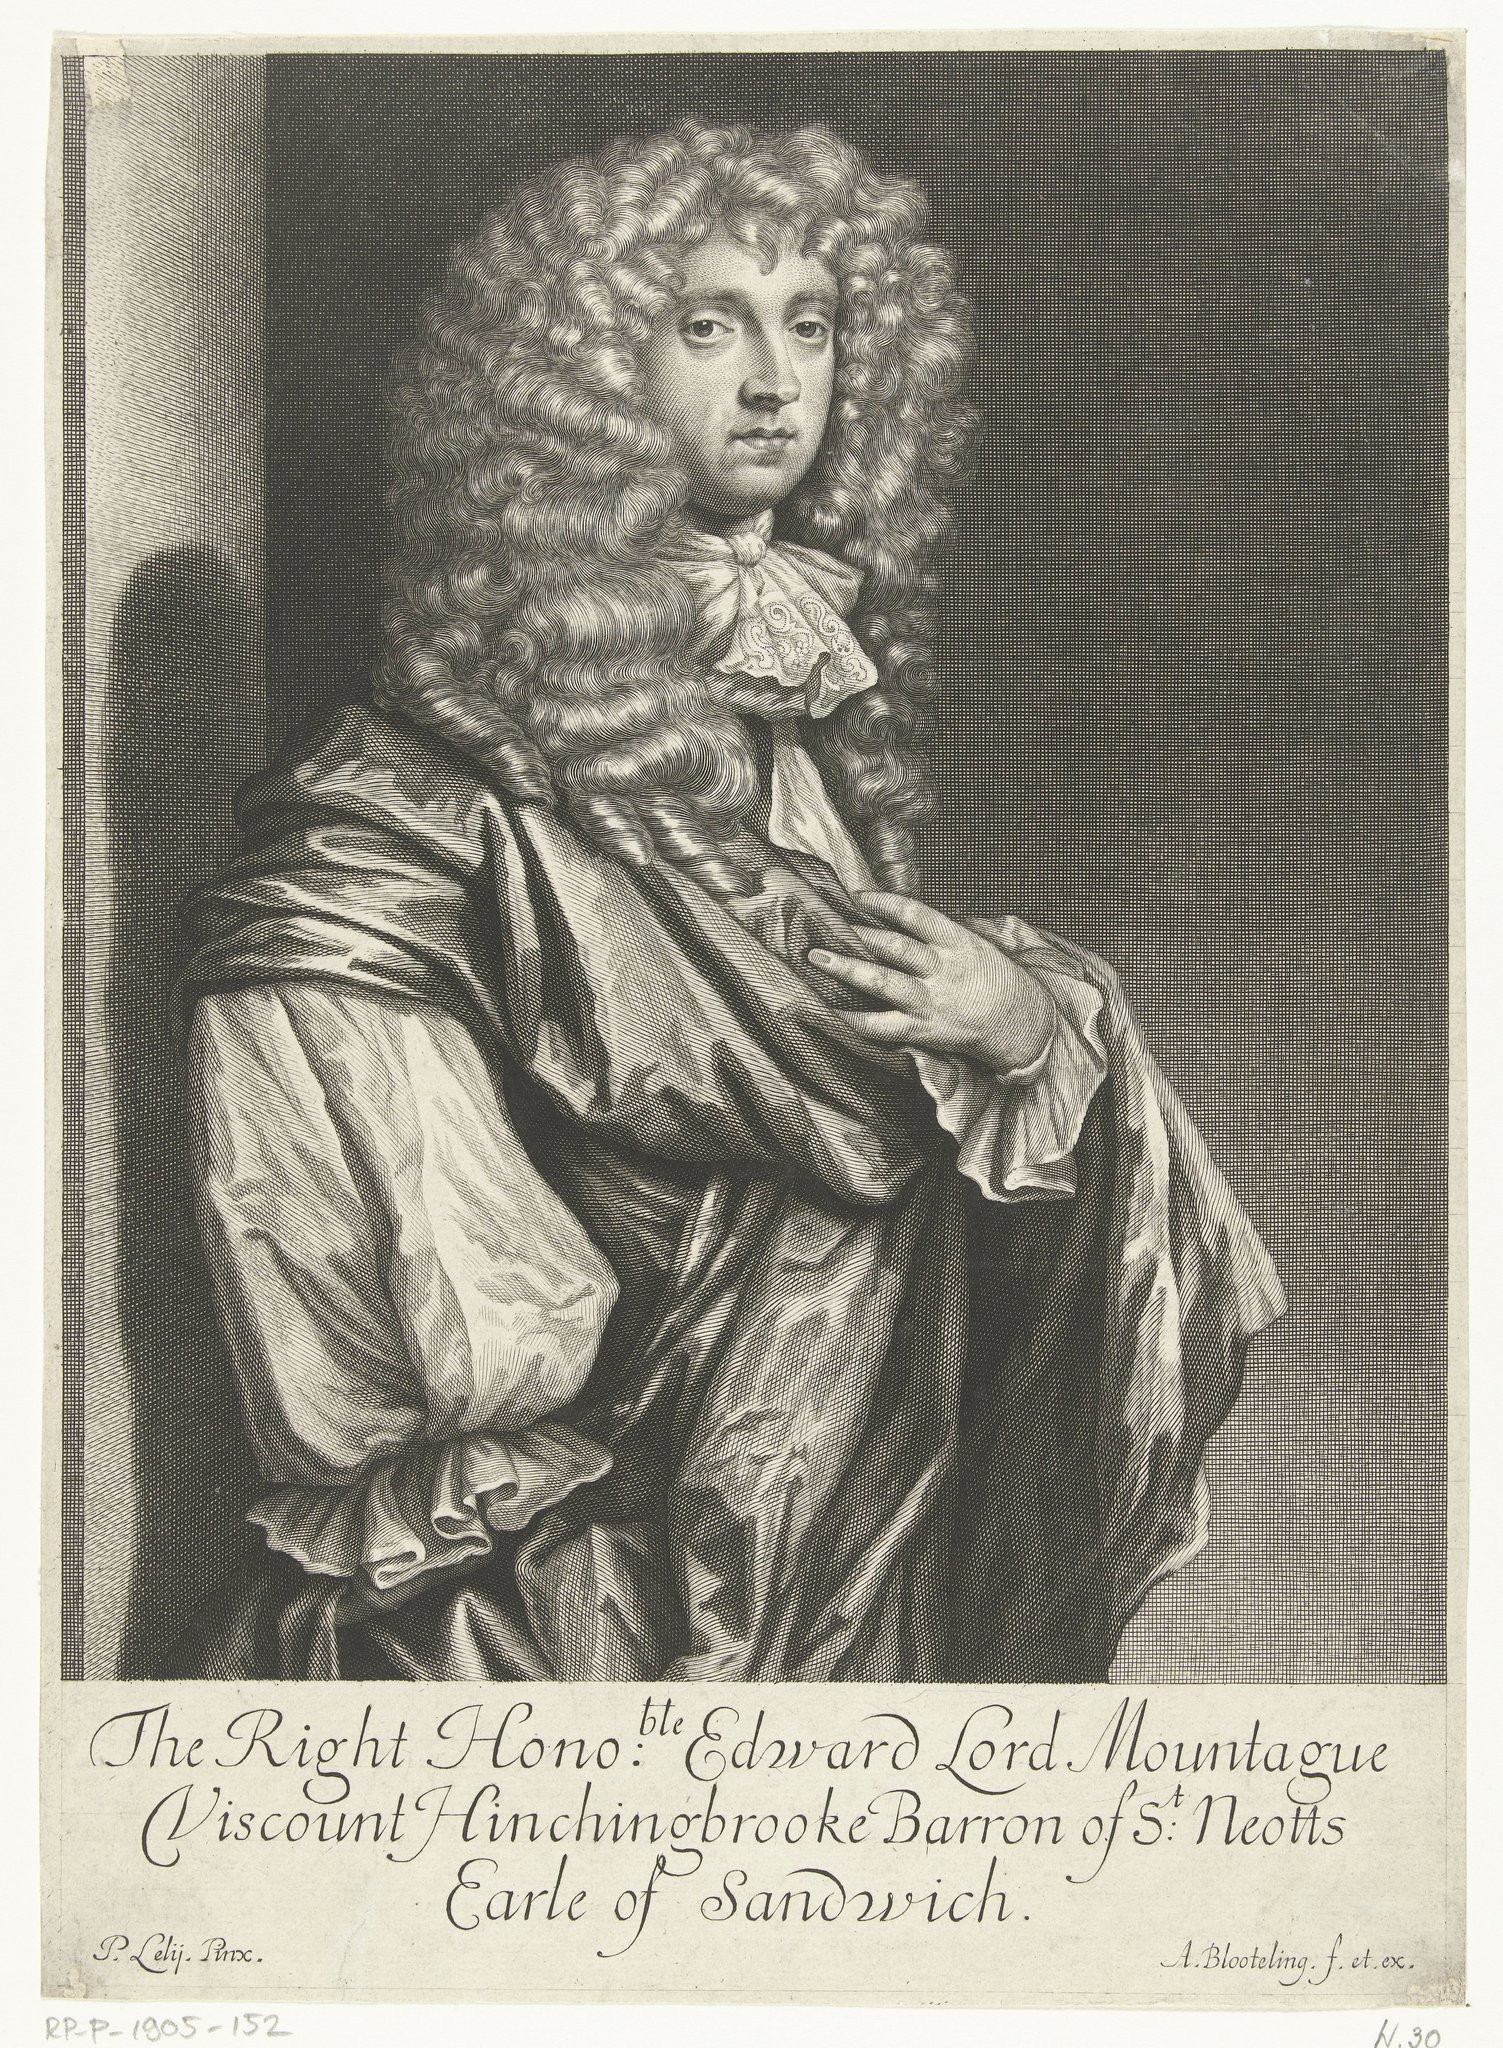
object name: print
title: Portret van Edward Montague (II), graaf van Sandwich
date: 1672-1678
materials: paper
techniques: engraving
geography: london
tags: edward montagu (2nd earl of sandwich)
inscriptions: collector's mark: Lugt 1008, collector's mark: Lugt 2228